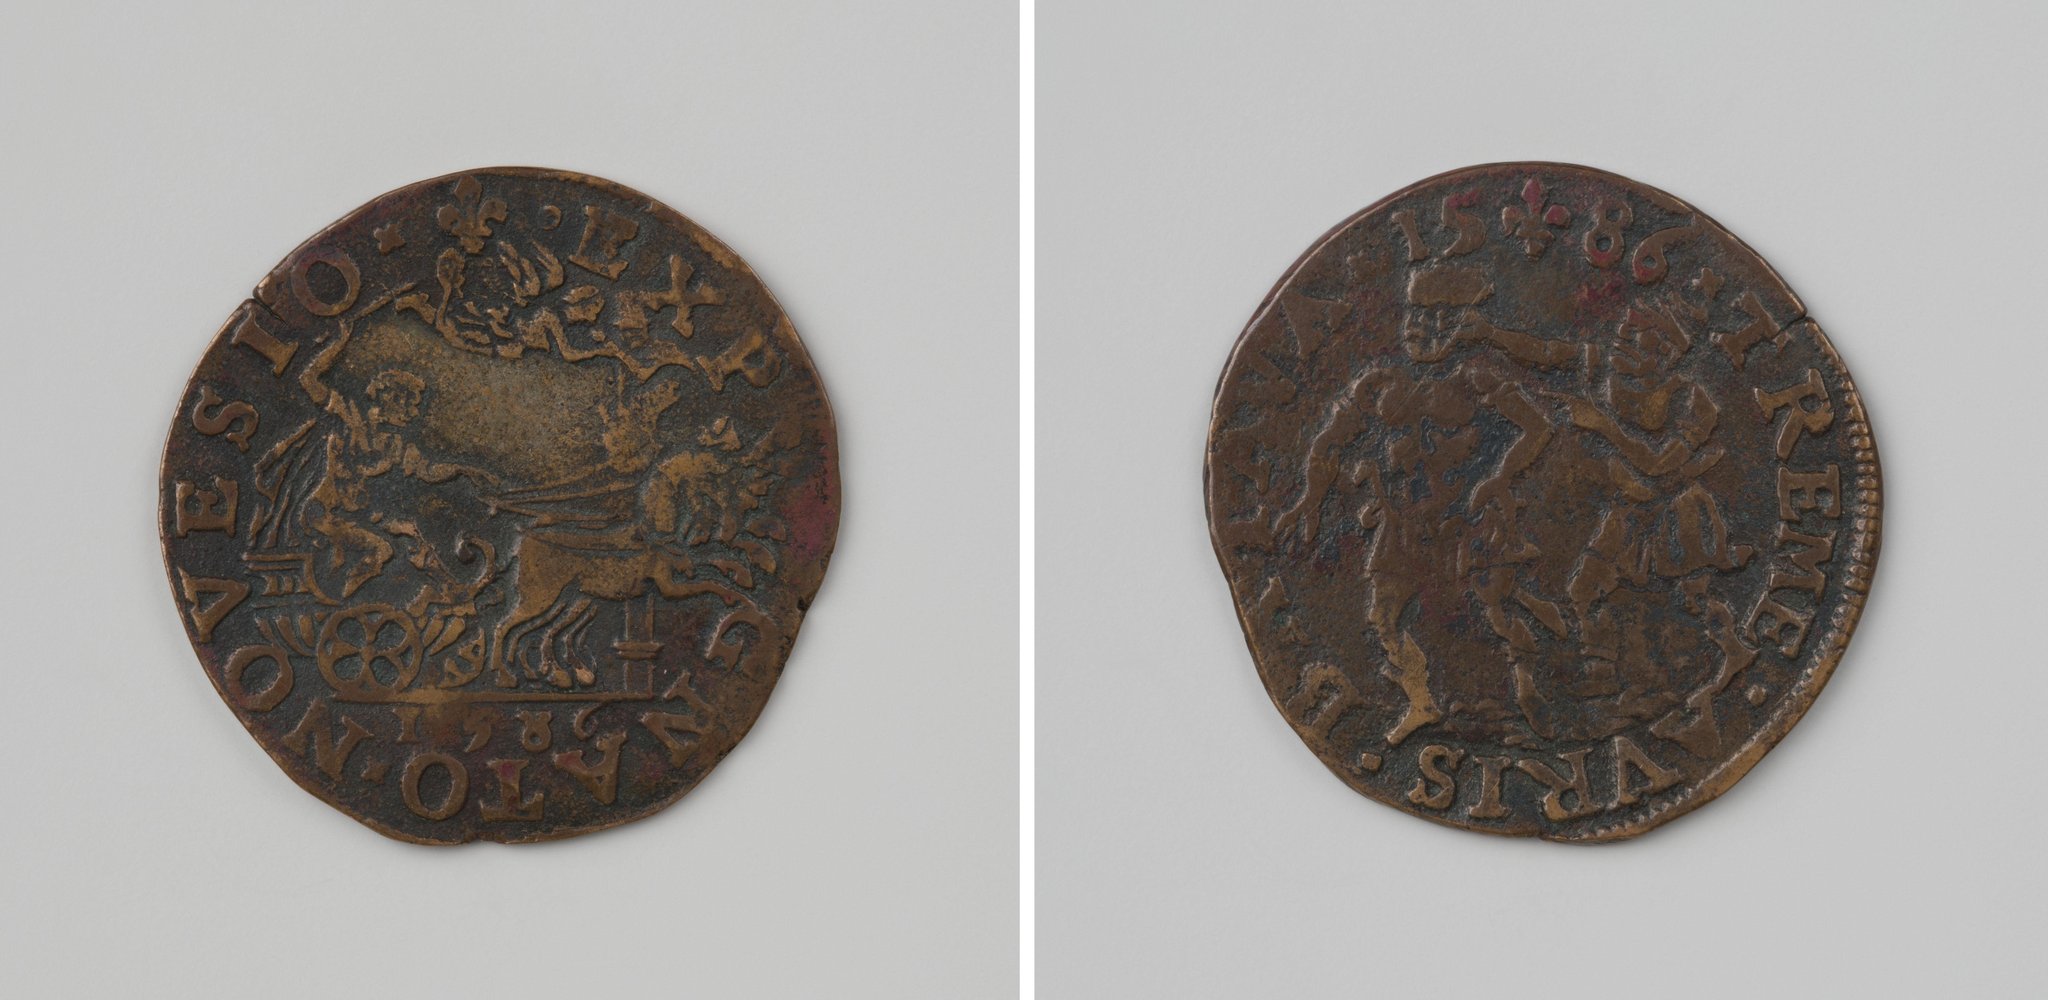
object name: jeton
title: Inname van Neuss door Alessandro Farnese, hertog van Parma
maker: Anonymous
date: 1586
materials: copper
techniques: striking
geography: bruges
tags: vienna, albert casimir van saksen-teschen, rome, alessandro farnese (landvoogd van de nederlanden en hertog van parma en piacenza)